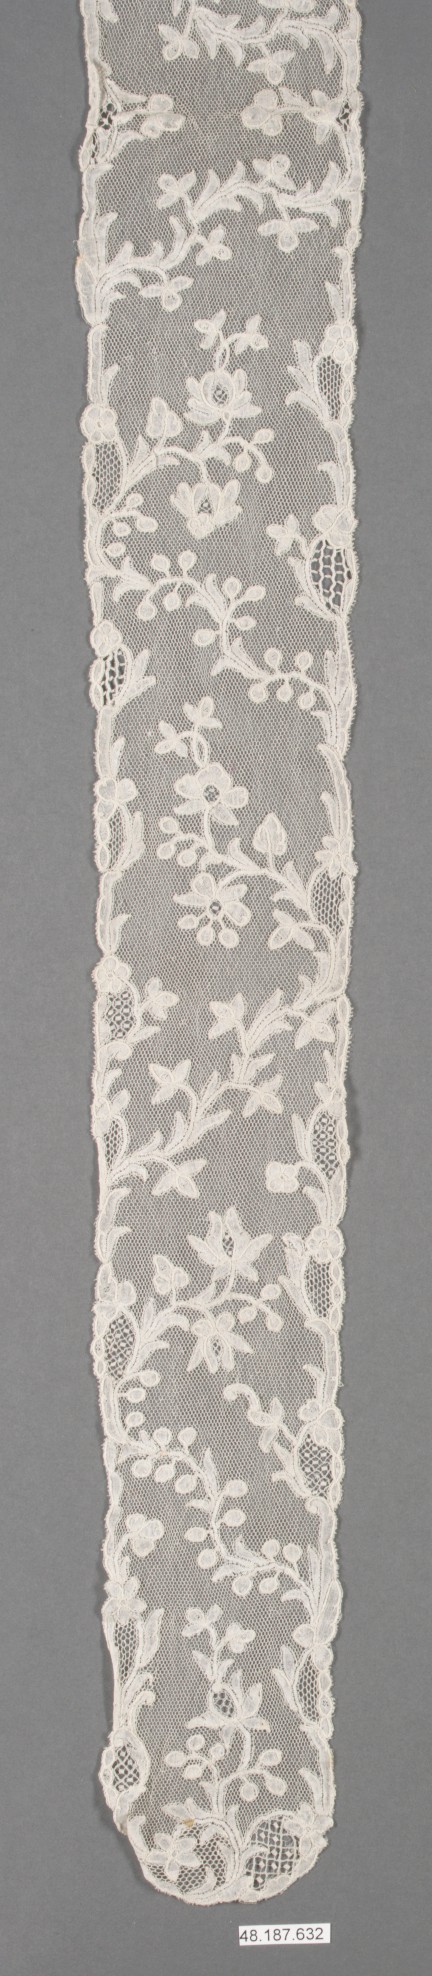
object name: barbe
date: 1767-1800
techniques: lace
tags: flowers